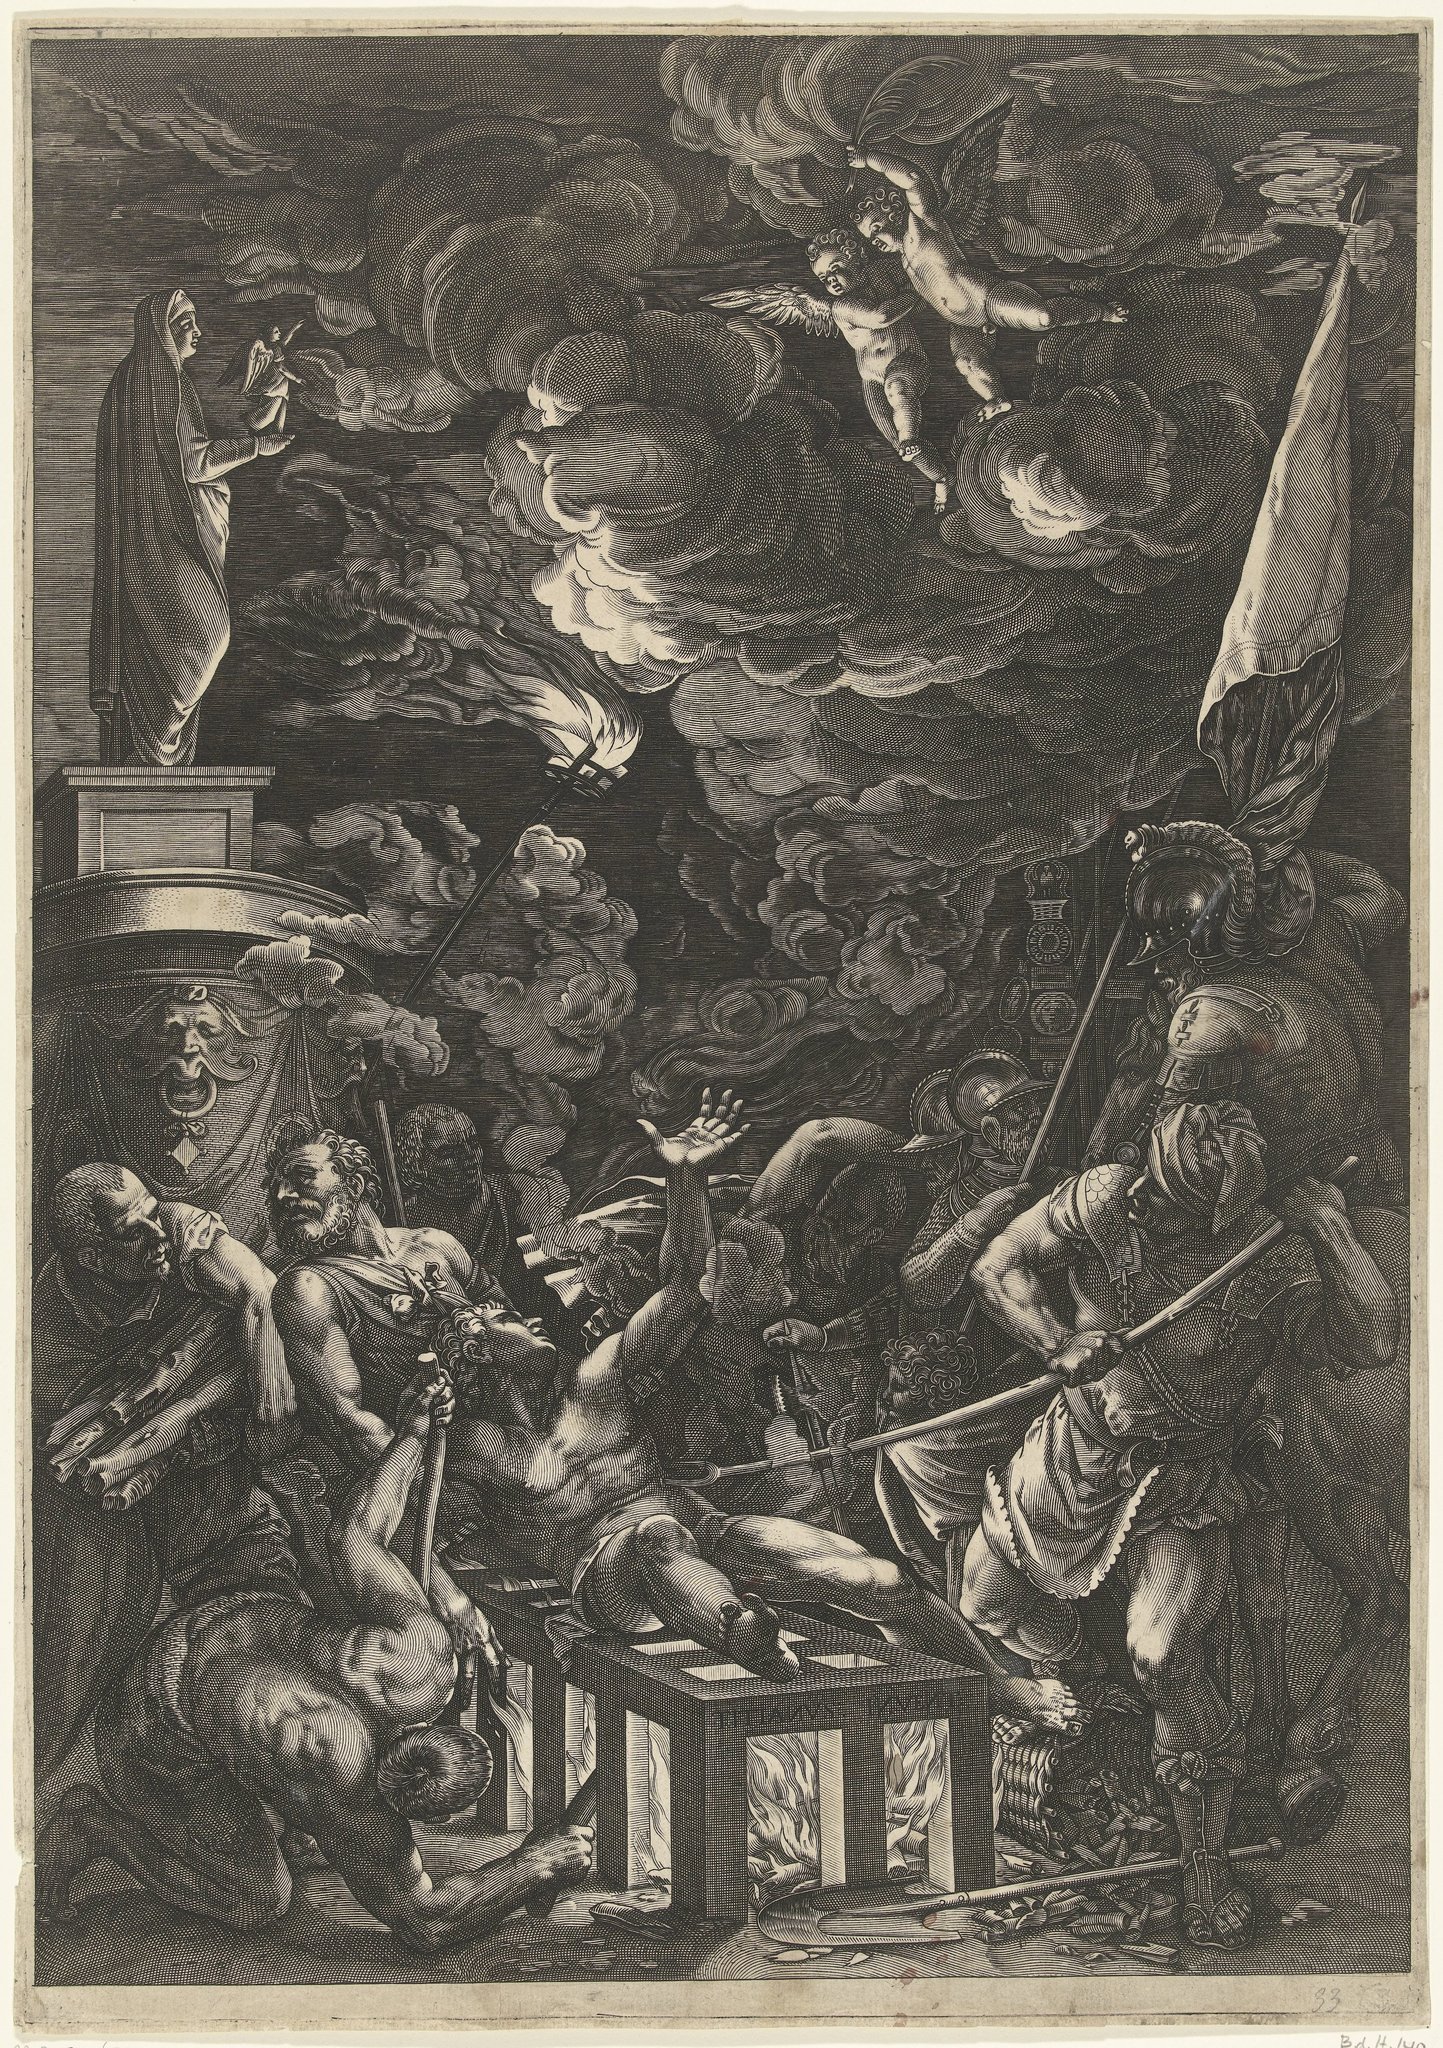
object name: print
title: De marteling van de H. Laurentius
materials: paper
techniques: engraving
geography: rome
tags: martyrdom, suffering, misfortune, death of st. laurence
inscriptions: collector's mark: Lugt 240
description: De heilige Laurentius ligt op een rooster en wordt gebraden. Soldaten halen hout voor het vuur, stoken het vuur op en steken met een spit in Laurentius zij. Op de achtergrond een standbeeld van Maria met een engel in haar hand. Twee engelen kijken vanuit de hemel naar de marteling van Laurentius en brengen hem alvast de palmtak, het teken van de martelaar.